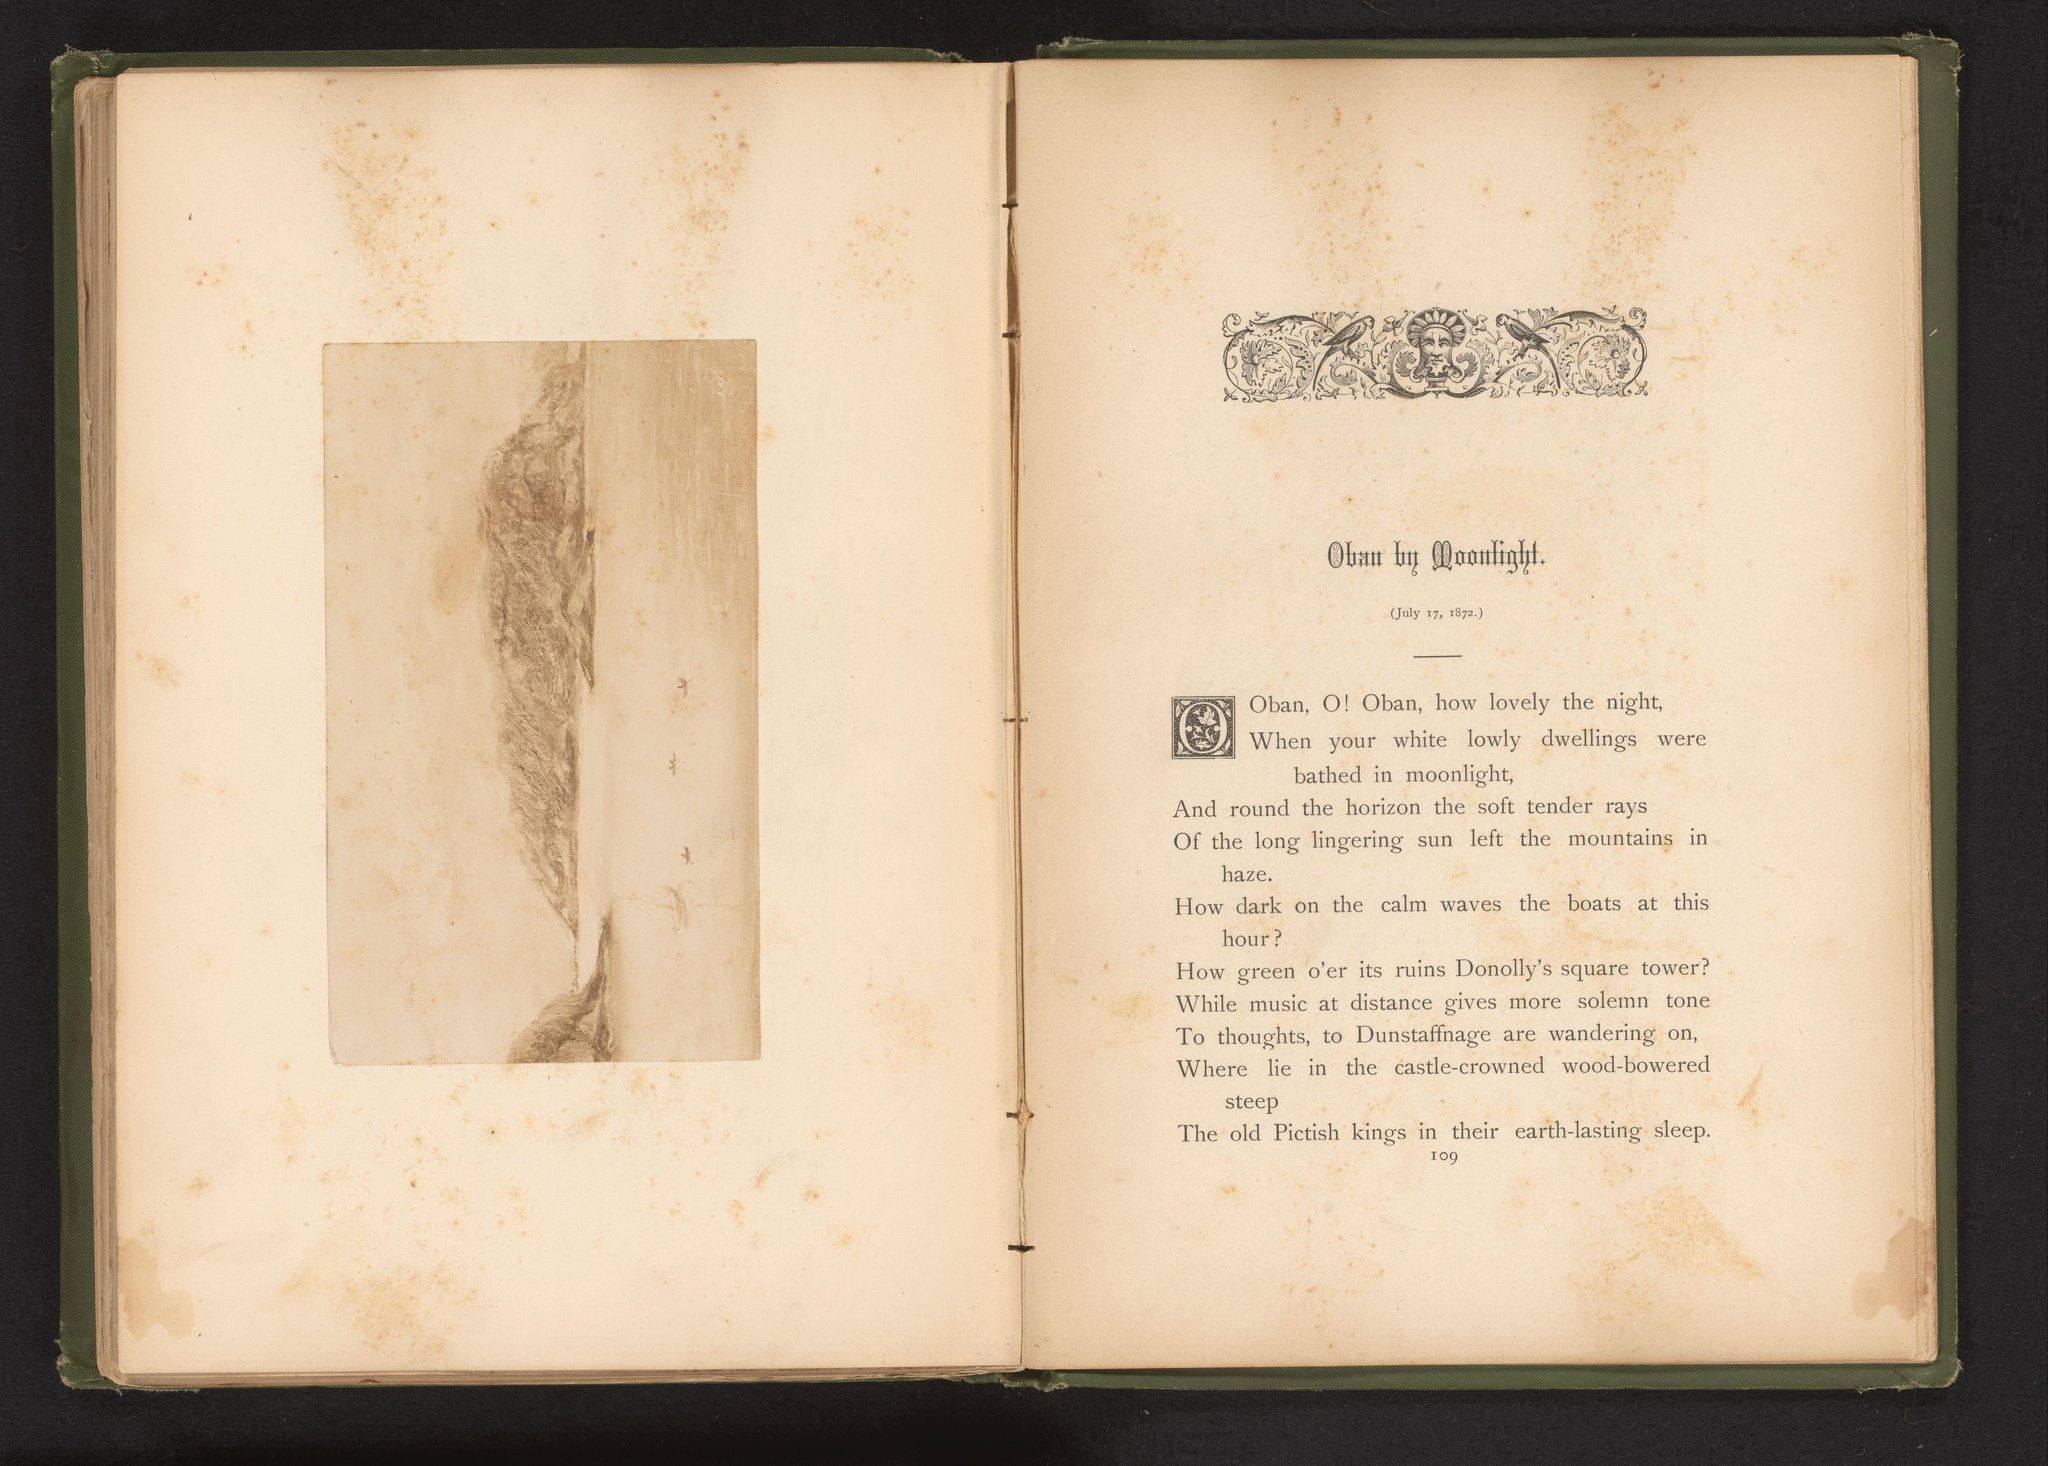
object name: page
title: Fotoreproductie van een tekening, voorstellende een gezicht op Oban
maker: Anonymous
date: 1871-1876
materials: photographic support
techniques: albumen print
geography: united states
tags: city-view in general; 'veduta'